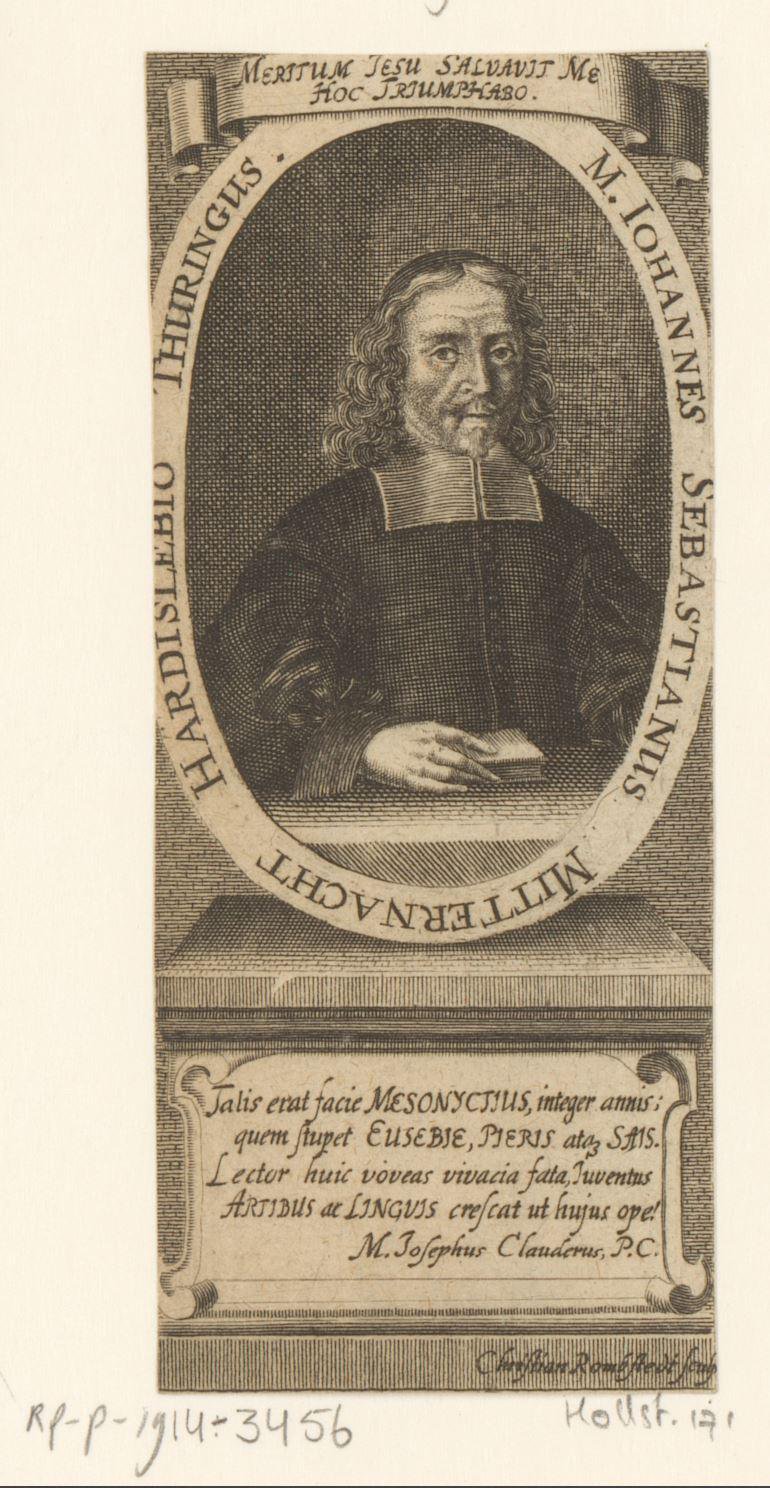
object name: print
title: Portret van Johann Sebastian Mitternacht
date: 1665-1721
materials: paper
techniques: engraving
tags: historical persons, book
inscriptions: collector's mark: Lugt 2228